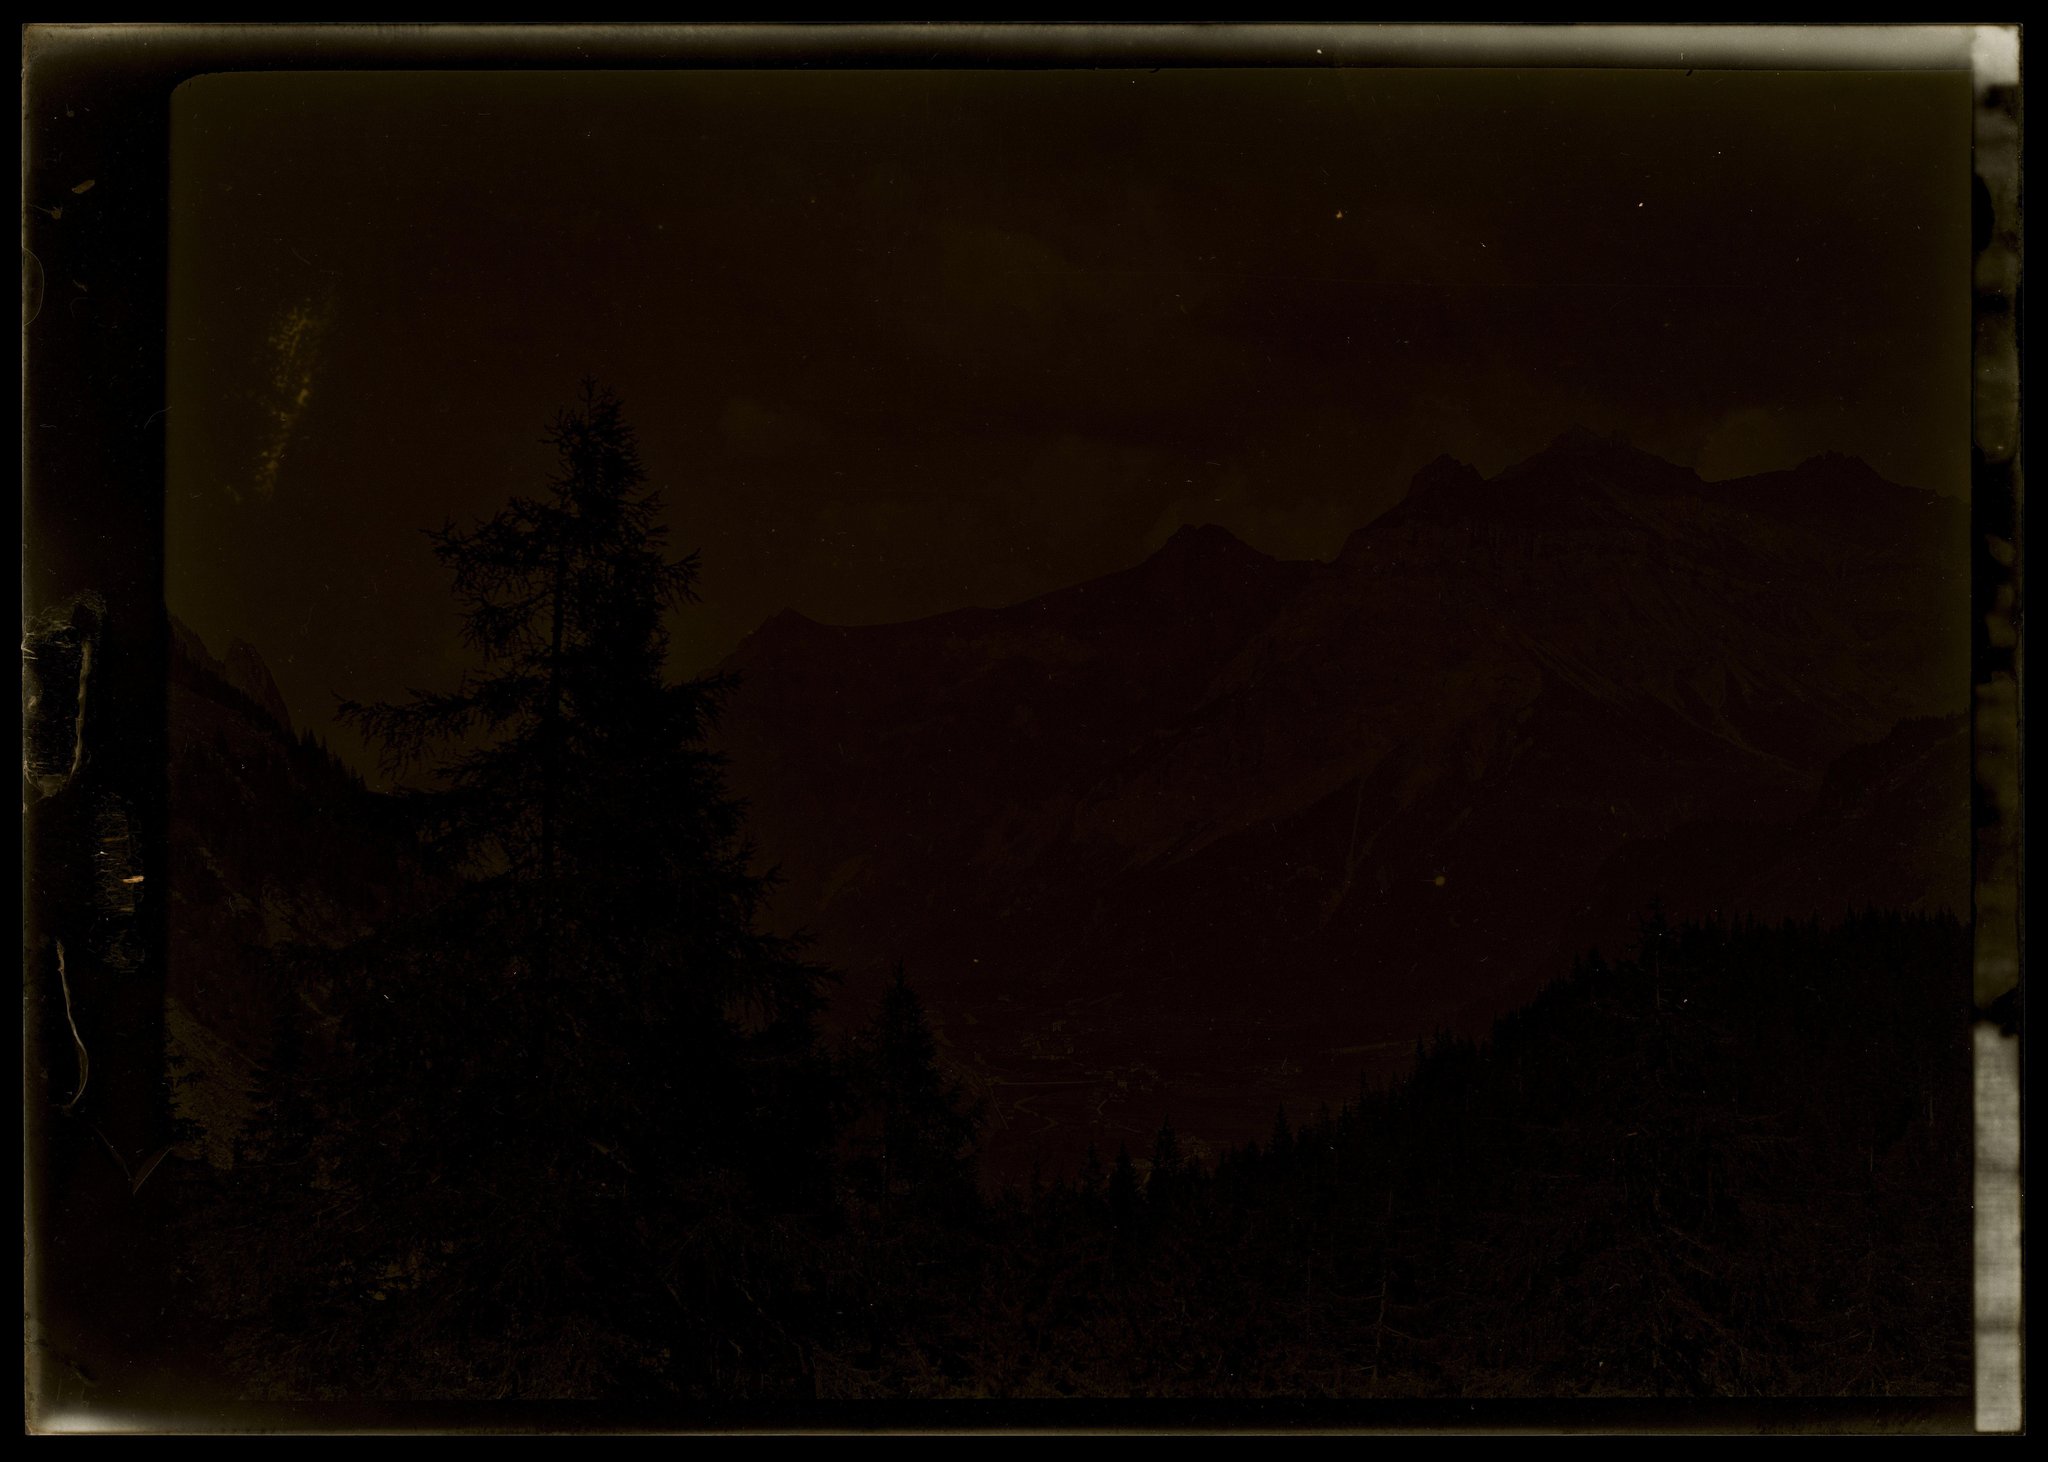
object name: photograph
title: Filmnegatief met opname van Basel, Thun, Kandersteg of Gemmi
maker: Anonymous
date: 1921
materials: film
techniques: gelatin silver negative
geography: switzerland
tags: switzerland